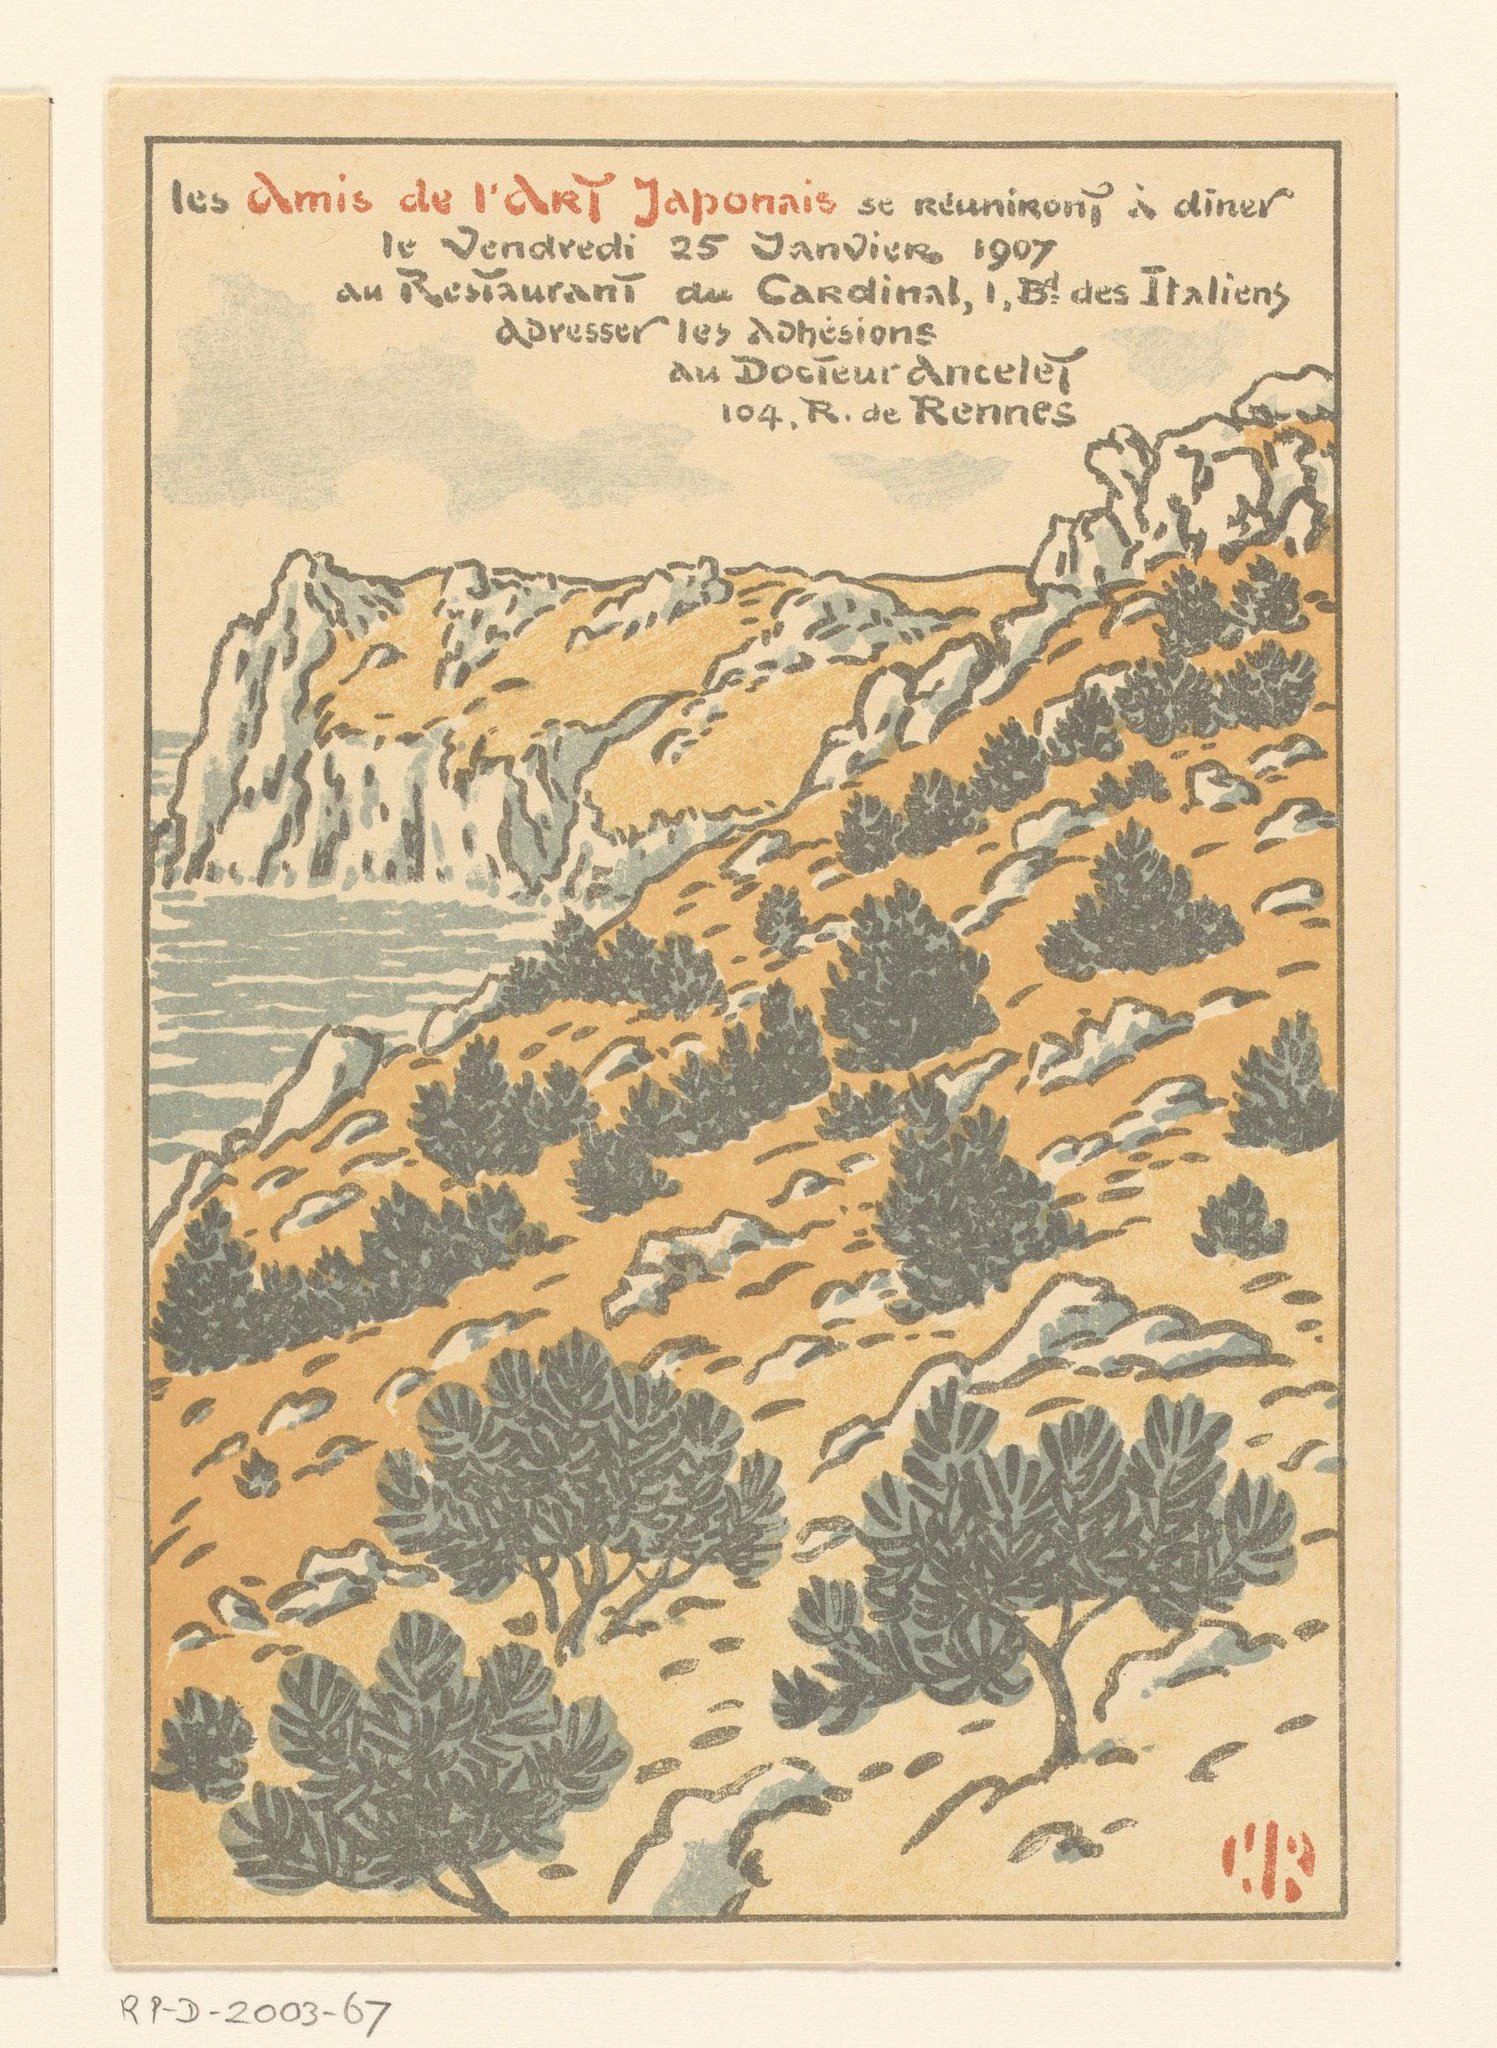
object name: invitation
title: Uitnodiging voor een diner van Les Amis de l'Art Japonais, 25 januari 1907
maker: henri rivière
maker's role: draughtsman, print maker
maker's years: 1864-1951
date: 1901-1907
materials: paper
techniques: woodcut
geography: france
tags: rocky coast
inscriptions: collector's mark: Lugt 2228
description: Rotsige kustlandschap. Uitnodiging voor een diner van Les Amis de l'Art Japonais, 25 januari 1907.